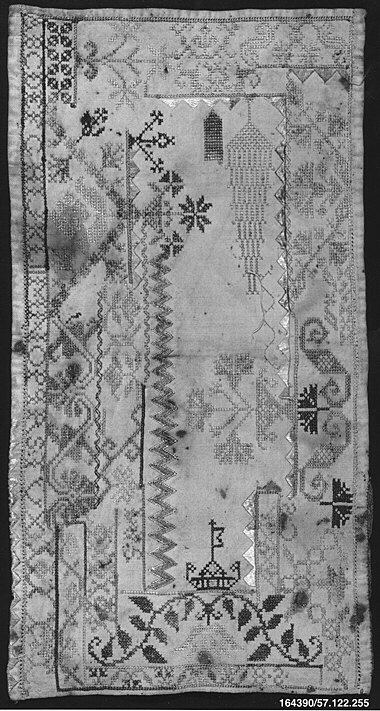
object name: sampler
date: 1801-1900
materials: cotton, silk